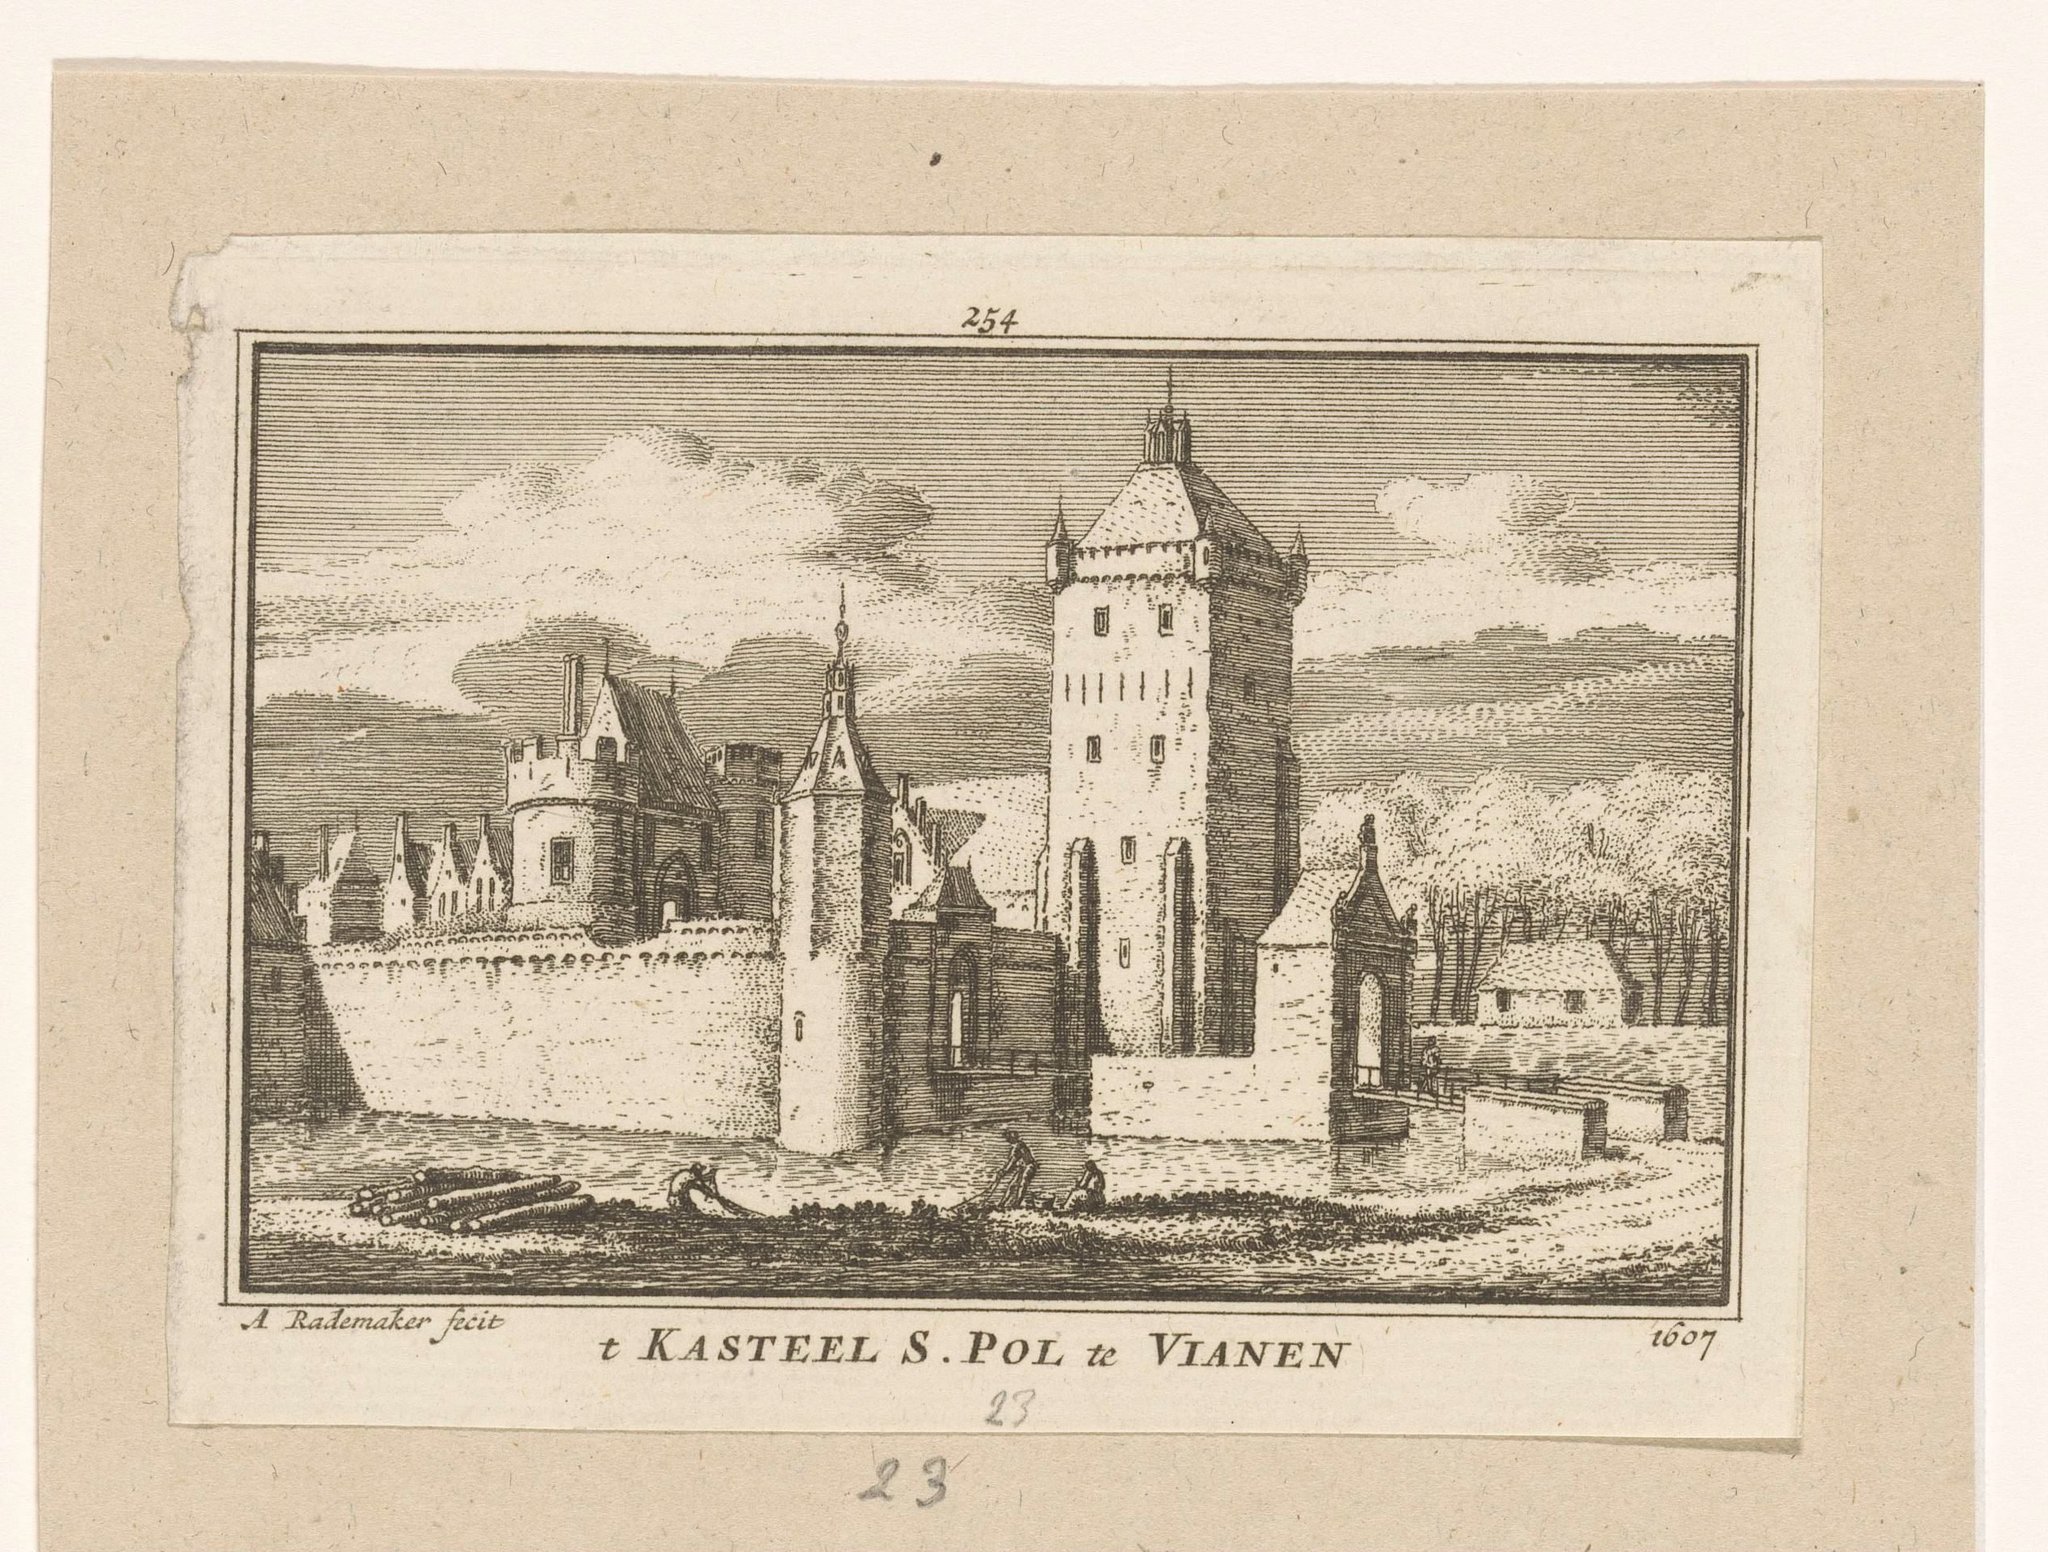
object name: book illustration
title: Kasteel S. Pol te Vianen 1607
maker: abraham rademaker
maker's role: draughtsman, print maker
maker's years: 1676-1735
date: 1725-1803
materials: paper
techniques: engraving, etching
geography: amsterdam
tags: castle, woodcutting, woodcutter ~ forestry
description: Prent ook gebruikt in: Rademaker, Abraham. Kabinet van Nederlandsche outheden en gezichten: vervat in 300 konstplaaten (…). 2 delen. Amsterdam: Willem Barents, 1725, dl. 2, ill. 254. Na 1725 is deze prent nog in verschillende heruitgaven verschenen, uitgegeven in 1727-1733, 1770-1771 en 1792-1803. Uit welke uitgave het huidige exemplaar precies komt is niet na te gaan.